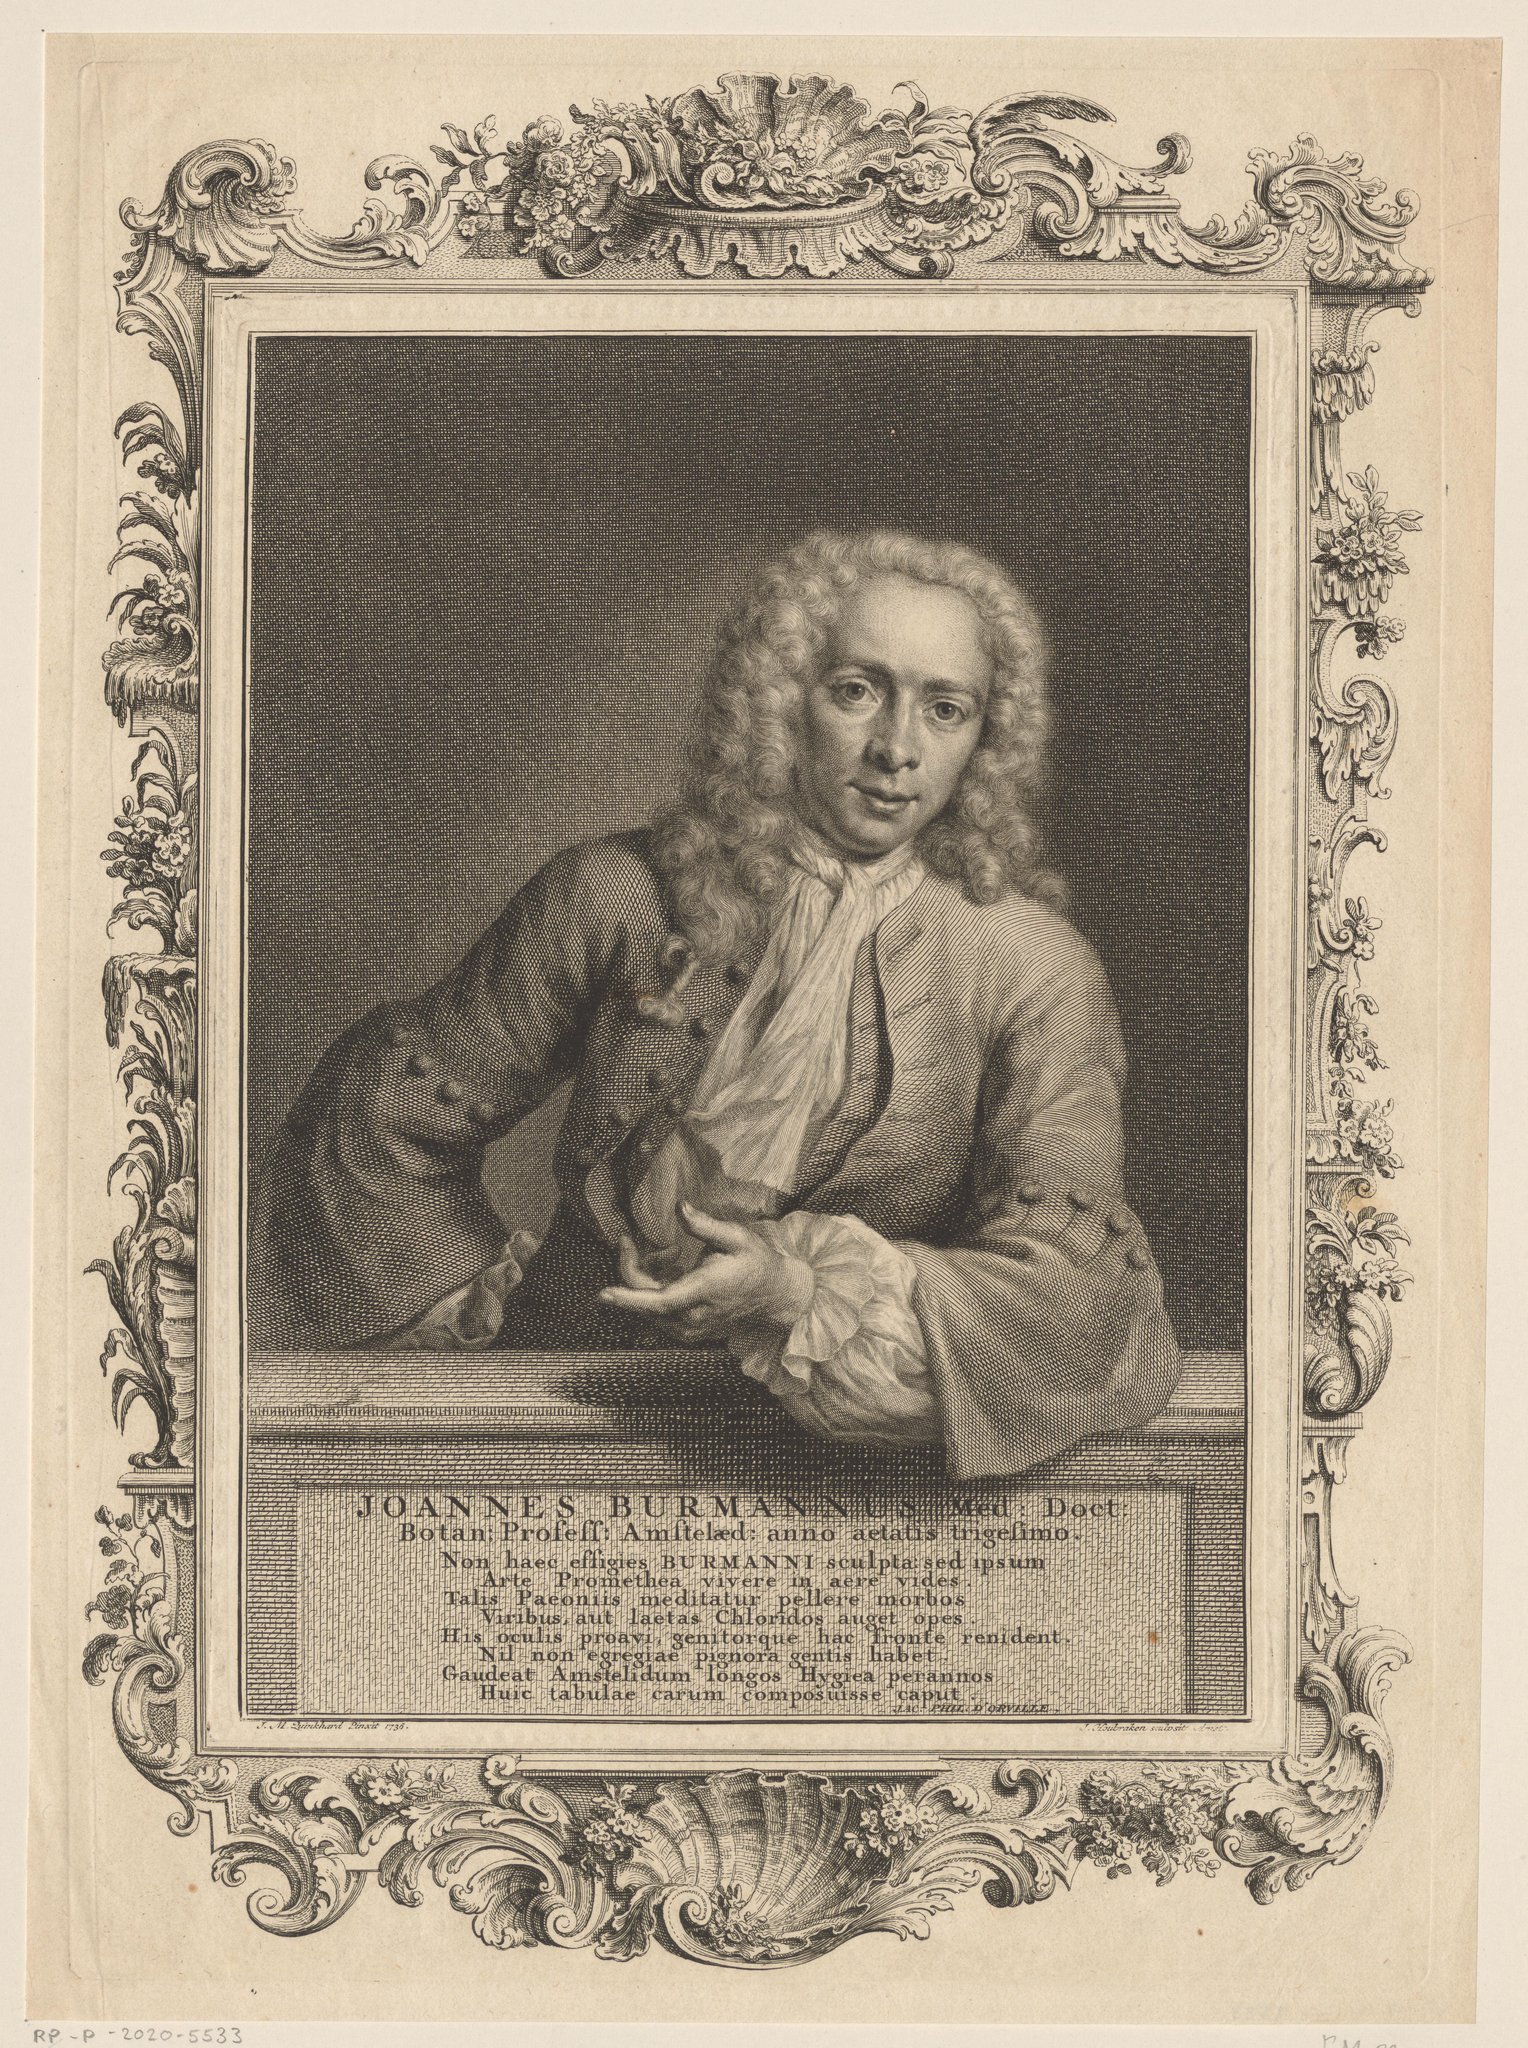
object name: print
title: Portret van Johannes Burman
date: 1736-1780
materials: paper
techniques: engraving, etching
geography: amsterdam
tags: amsterdam, historical persons, physician, doctor